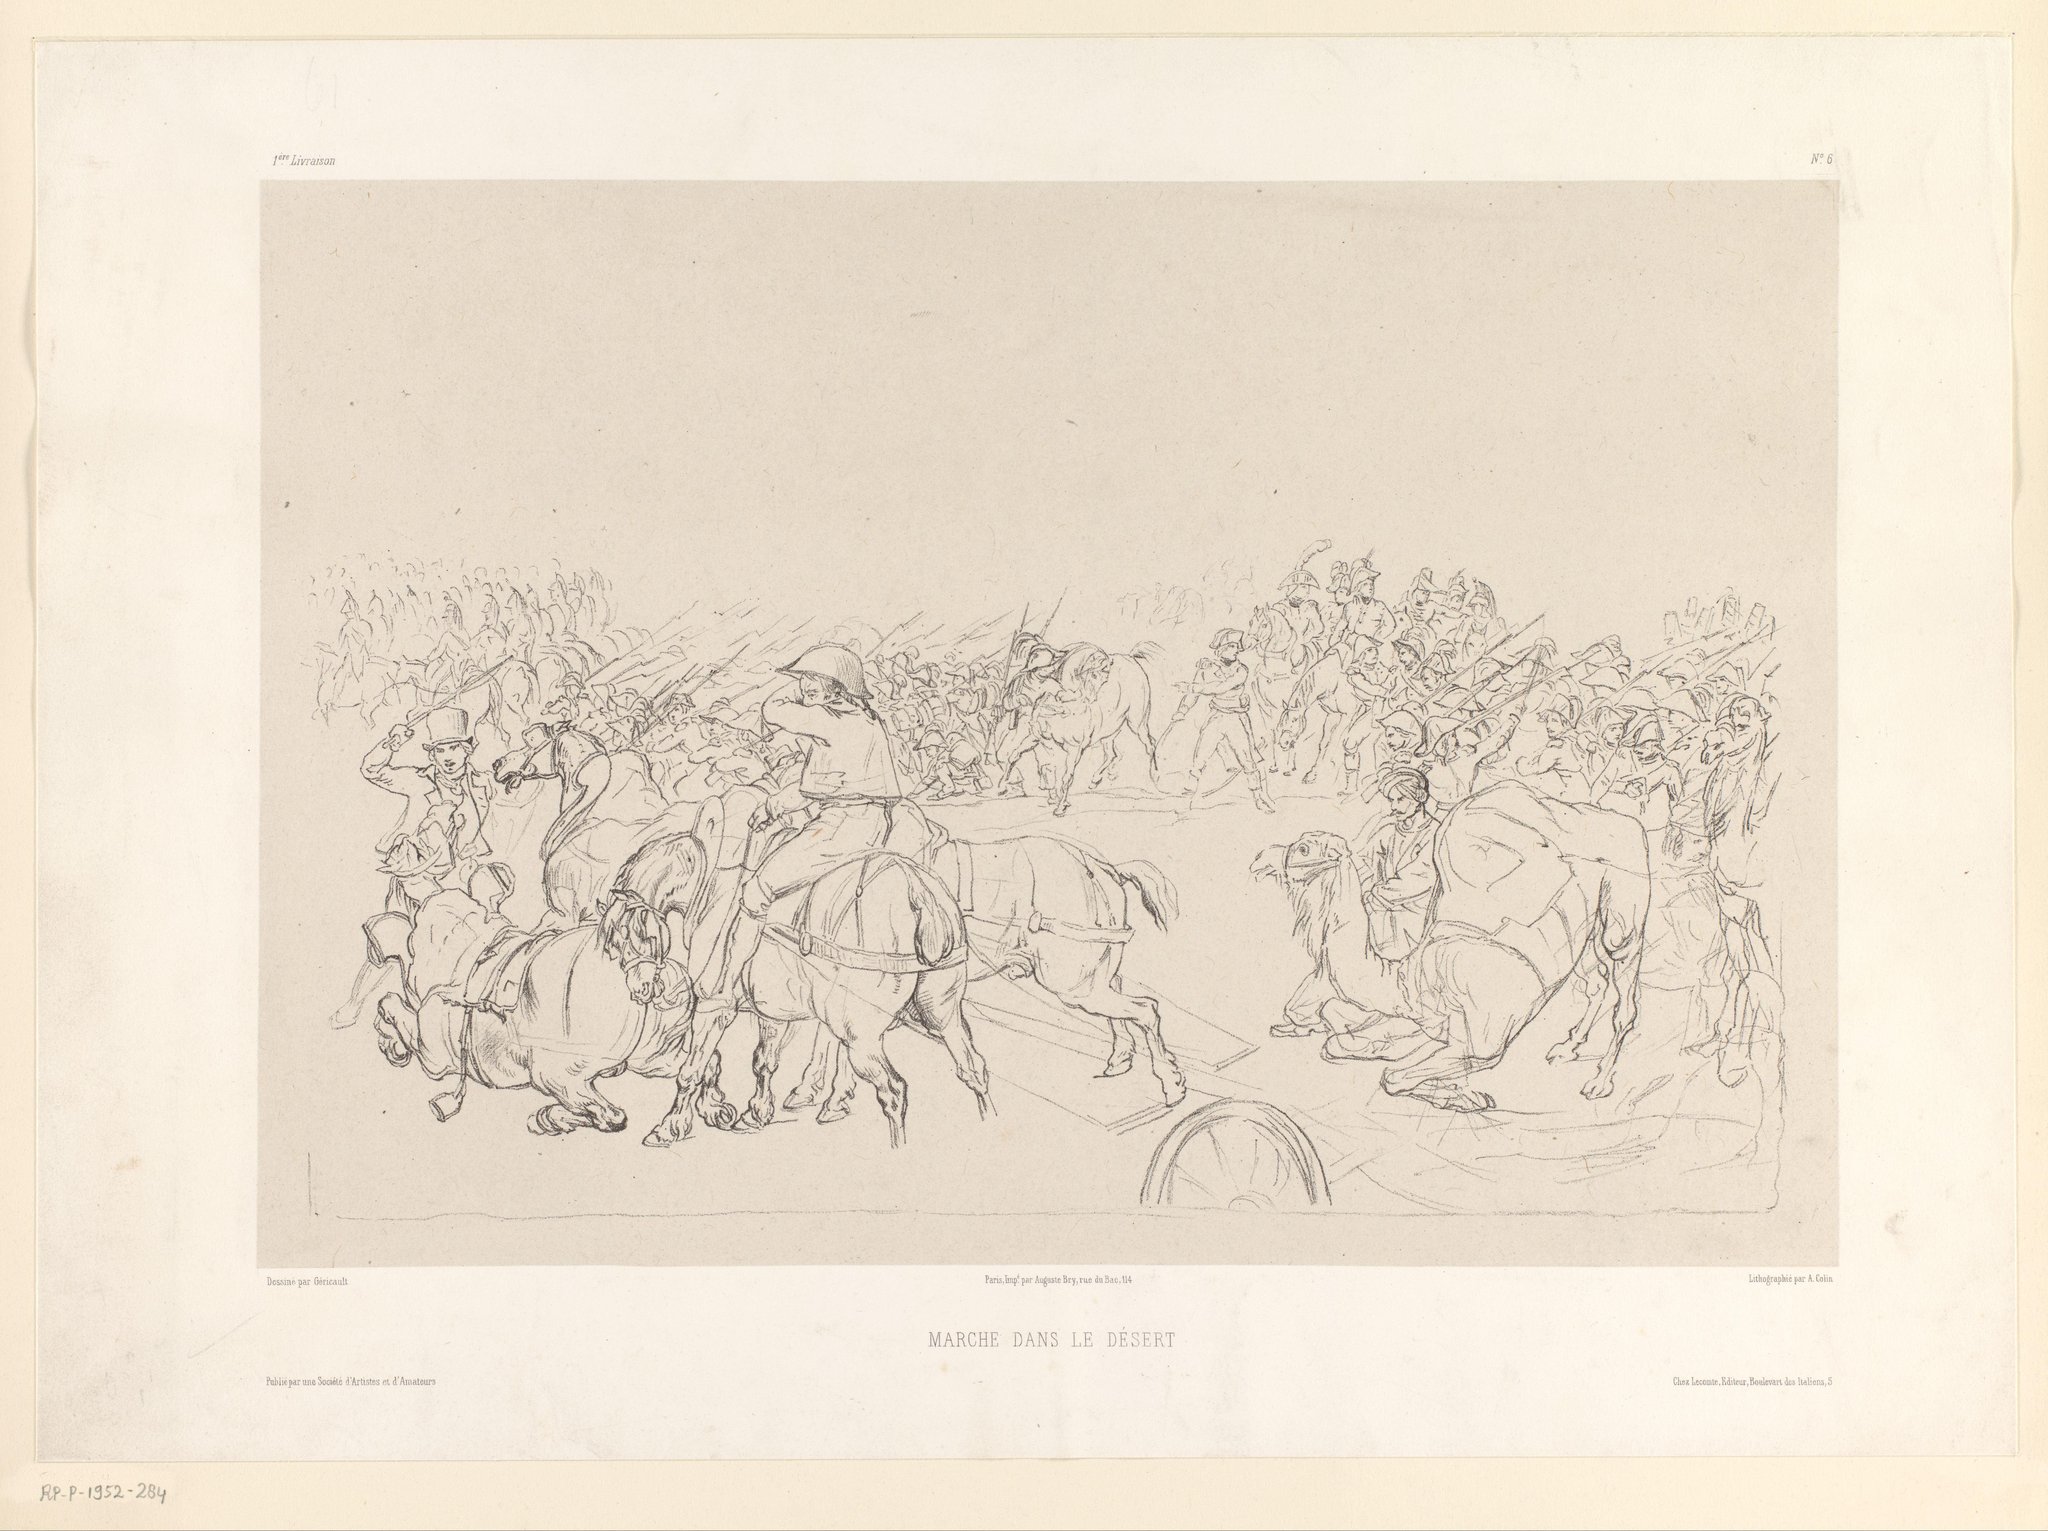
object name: print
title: Tekeningen van Géricault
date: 1866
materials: paper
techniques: lithograph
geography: paris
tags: hoofed animals: camel, land forces (+ cavalry, horsemen), land forces (+ mounted troops on other animals than horses), battle, desert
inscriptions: collector's mark: Lugt 2228a